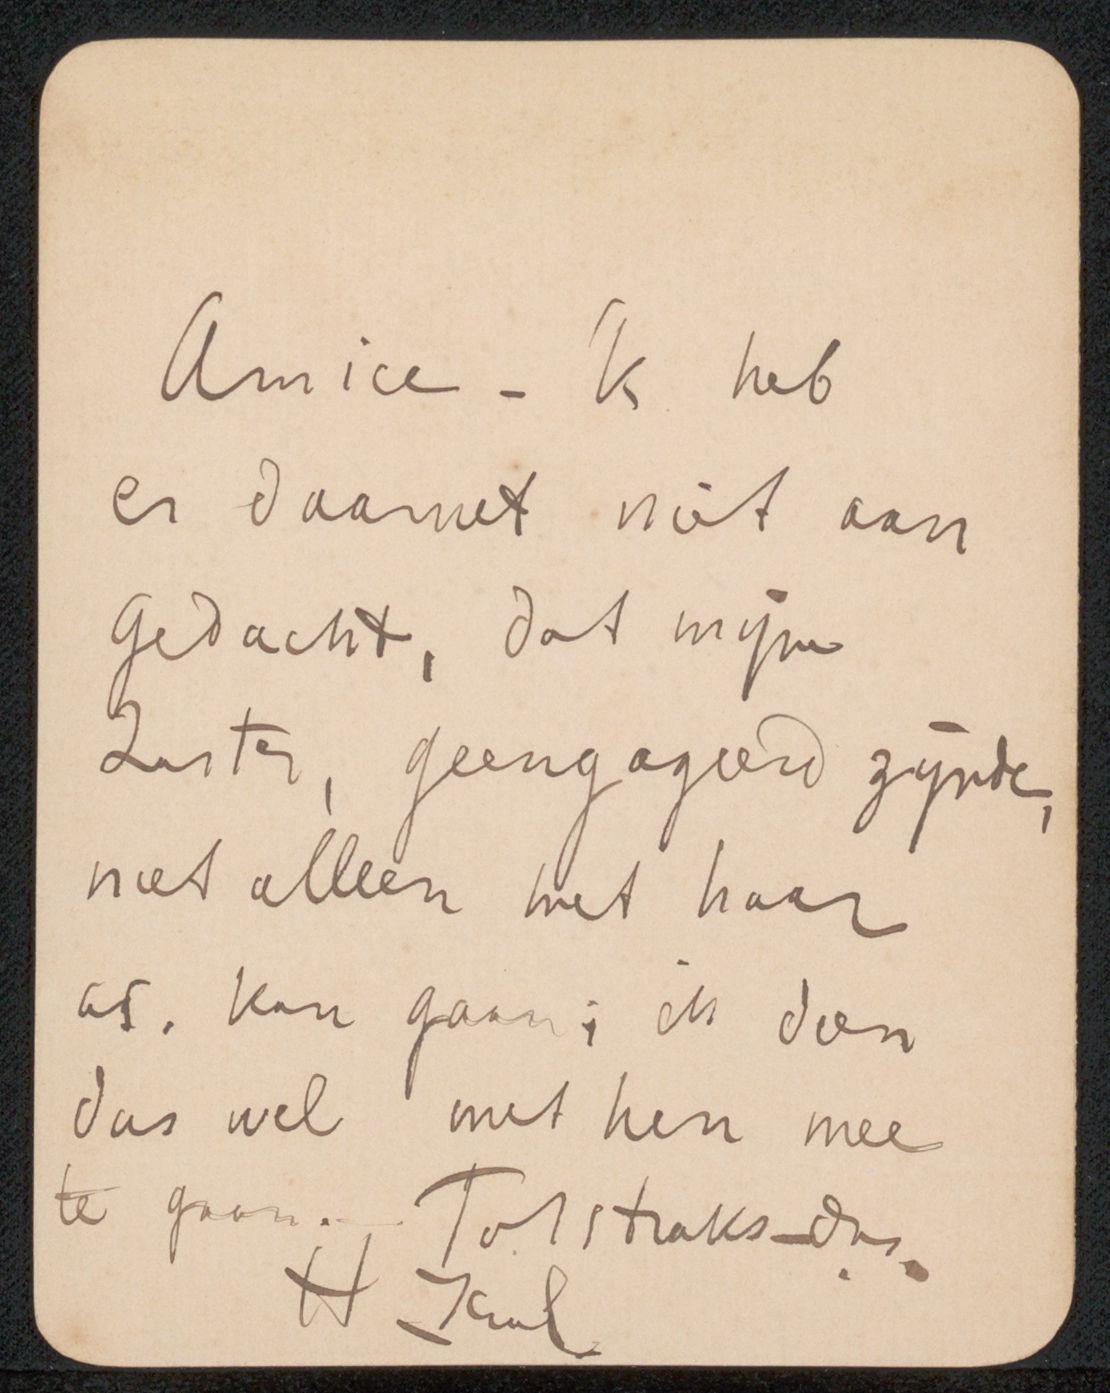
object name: letter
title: Brief aan Philip Zilcken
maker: jozef israëls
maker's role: draughtsman, painter, print maker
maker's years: 1824-1911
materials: cardboard, ink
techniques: pen, writing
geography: the hague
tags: the hague, painter, draughtsman, philip zilcken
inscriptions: collector's mark: ‘RPK’